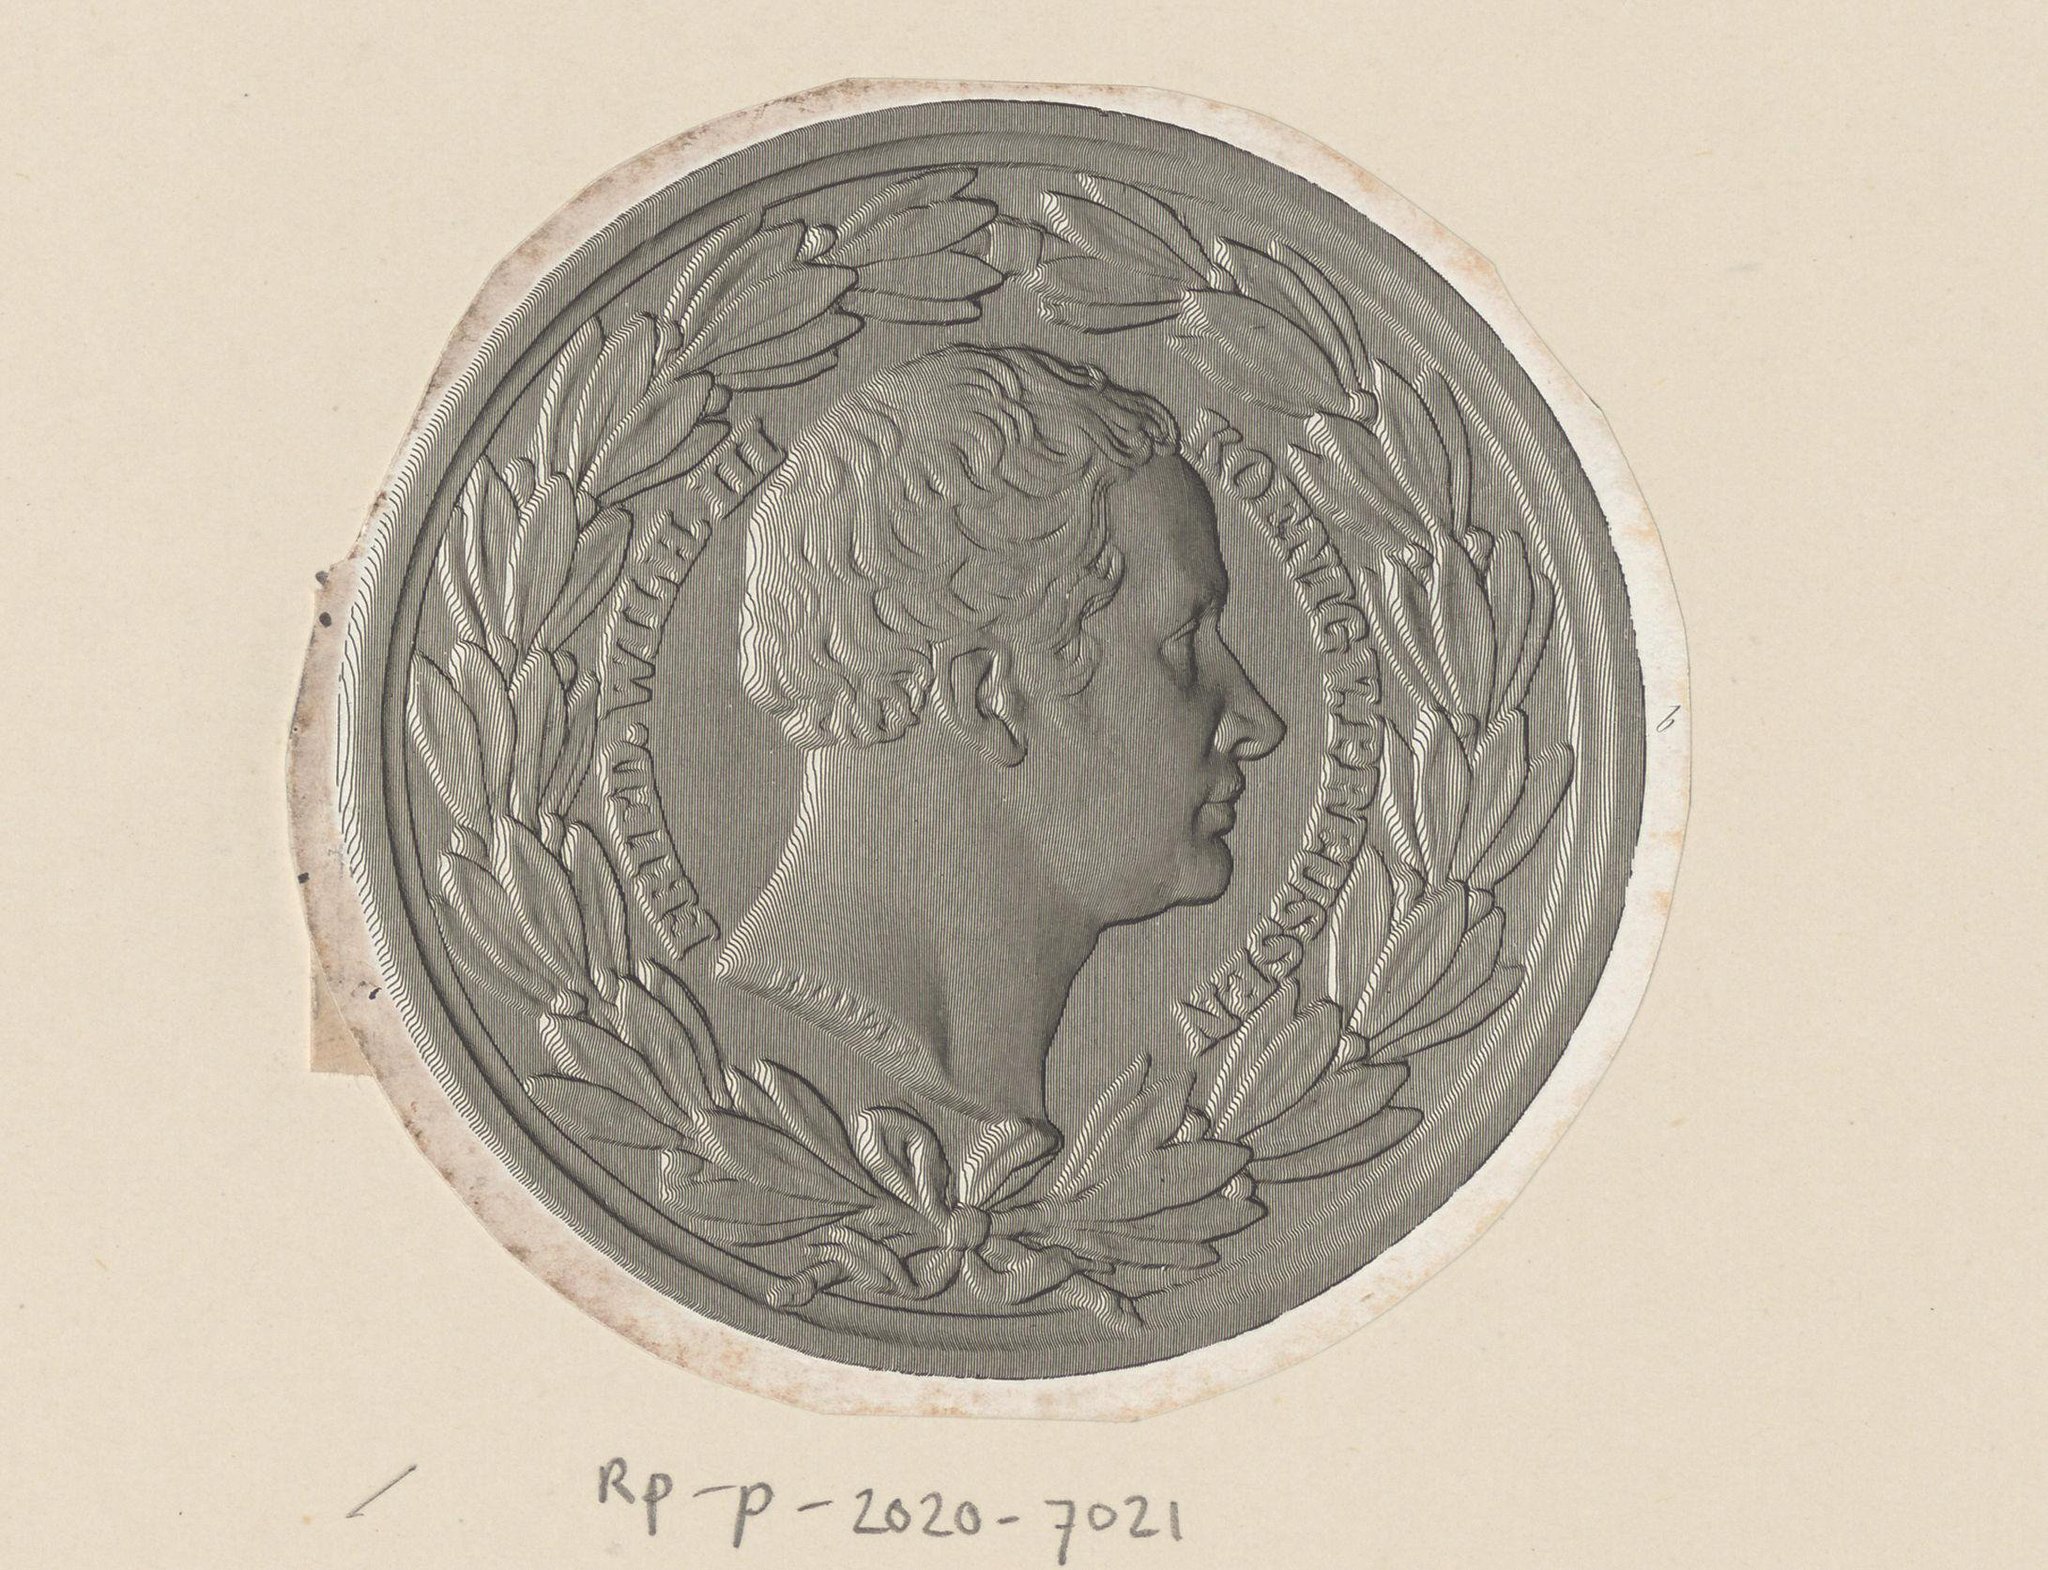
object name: print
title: Munt met portret van Frederik Willem IV van Pruisen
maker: Anonymous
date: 1840-1899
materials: paper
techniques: relief engraving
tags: berlin, frederik willem iv (koning van pruisen), historical persons, coin, king